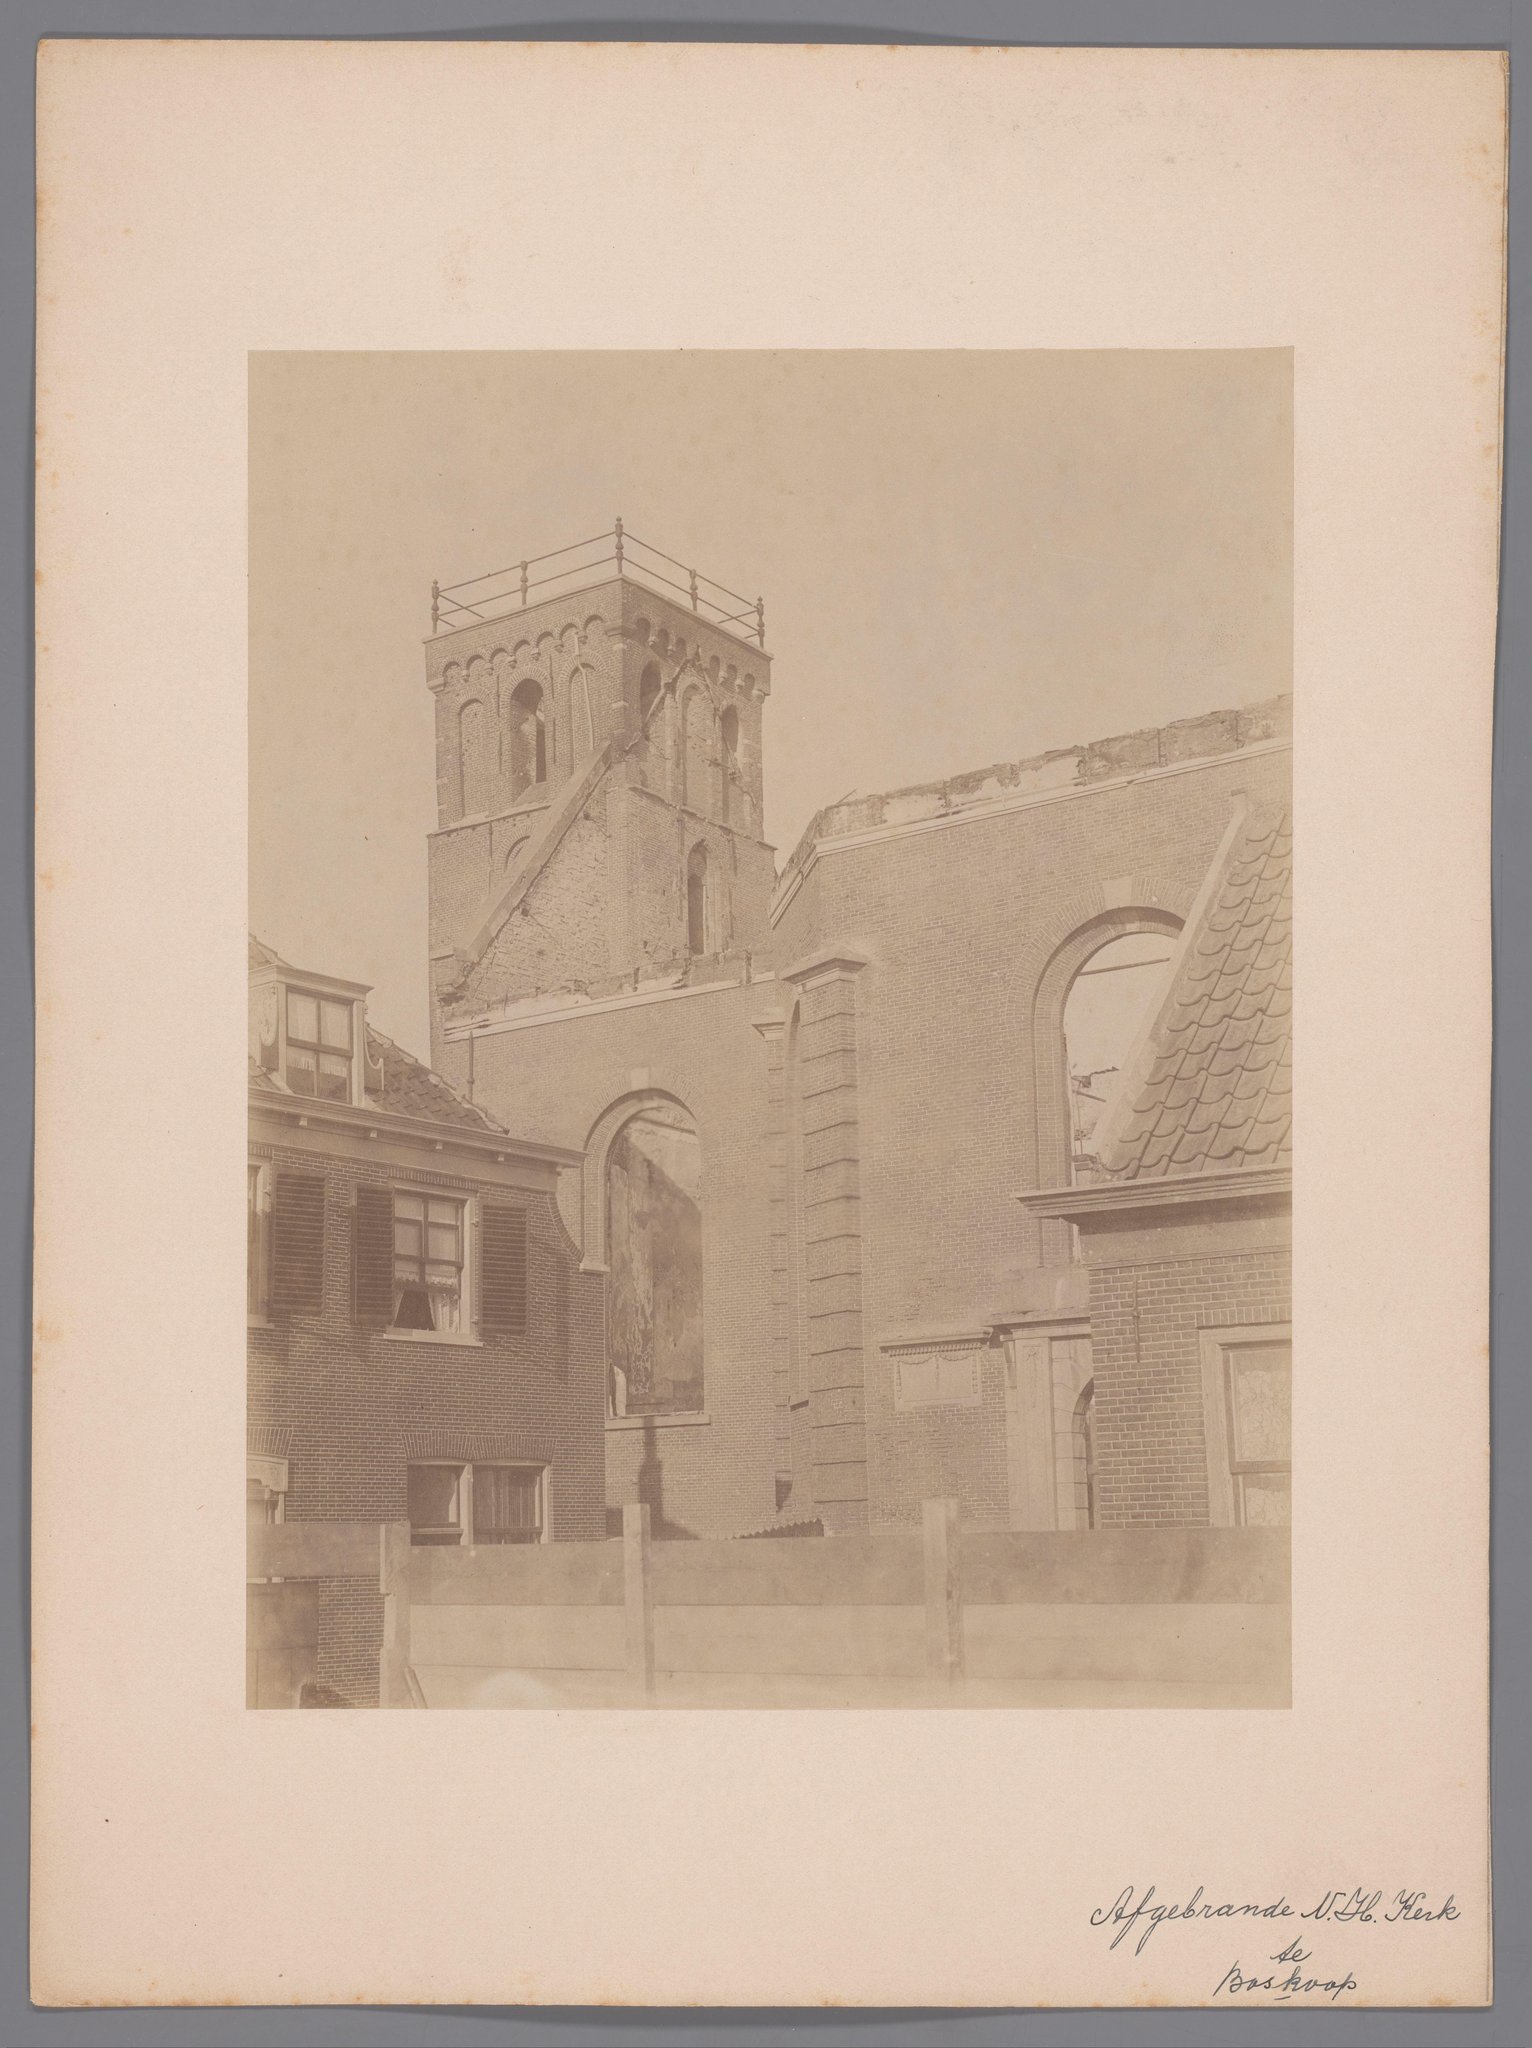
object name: photograph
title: Dorpskerk te Boskoop na de brand van 1895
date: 1895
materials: cardboard, photographic support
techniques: albumen print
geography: boskoop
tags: church (exterior), tower (of house or building)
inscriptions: annotation: ‘Afgebran N.H. Kerk te Boskoop’, annotation: ‘Afgebrand N.H. Kerk te Boskoop (Z.H’